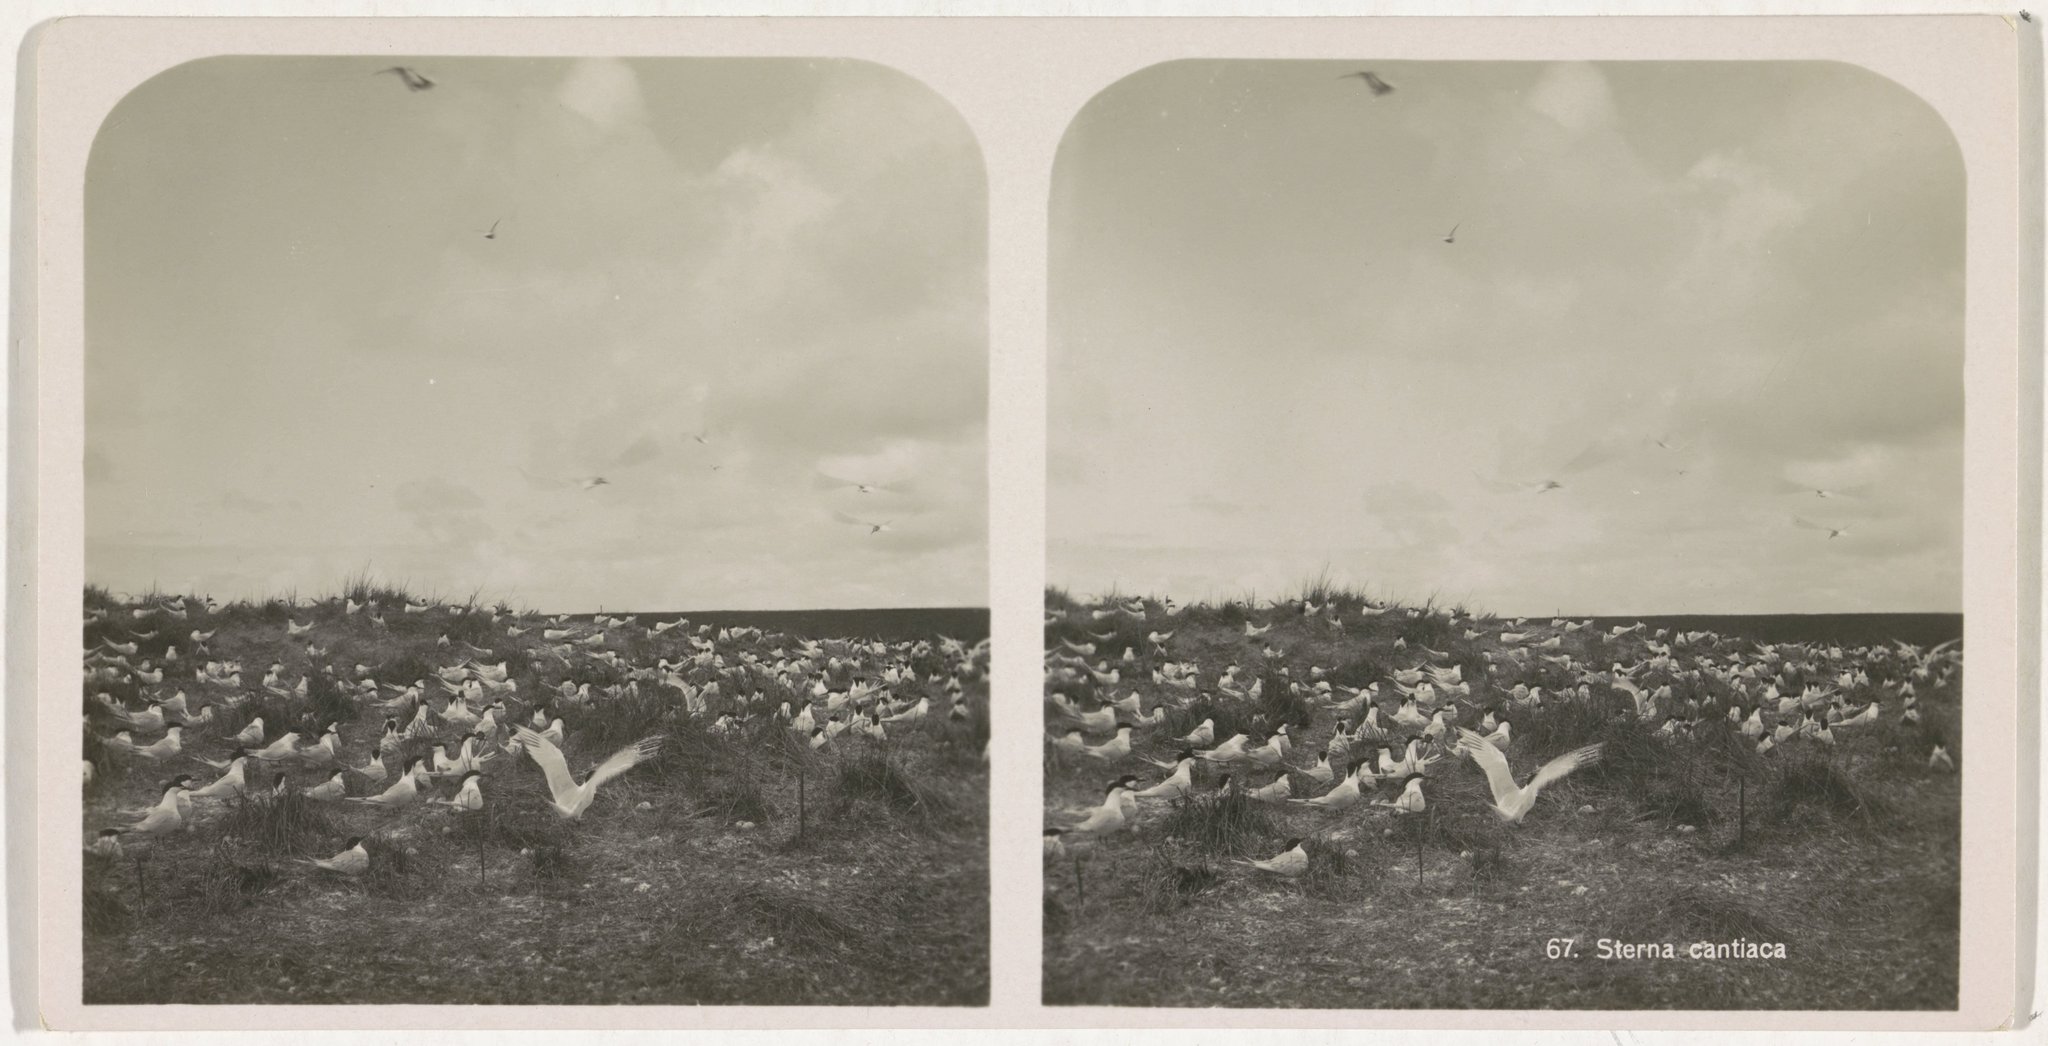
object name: stereograph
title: Groep zee-zwaluwen broedend op hun nesten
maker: adolphe burdet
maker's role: fotograaf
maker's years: 1860-1940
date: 1870-1940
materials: photographic support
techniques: gelatin silver print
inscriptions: label: ‘Zee Zwaluwen.’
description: De foto maakt deel uit van een serie van 12 stereofoto's, bewaard in het originele mapje. De foto's tonen zeevogels in natuurgebied De Bol op Texel.